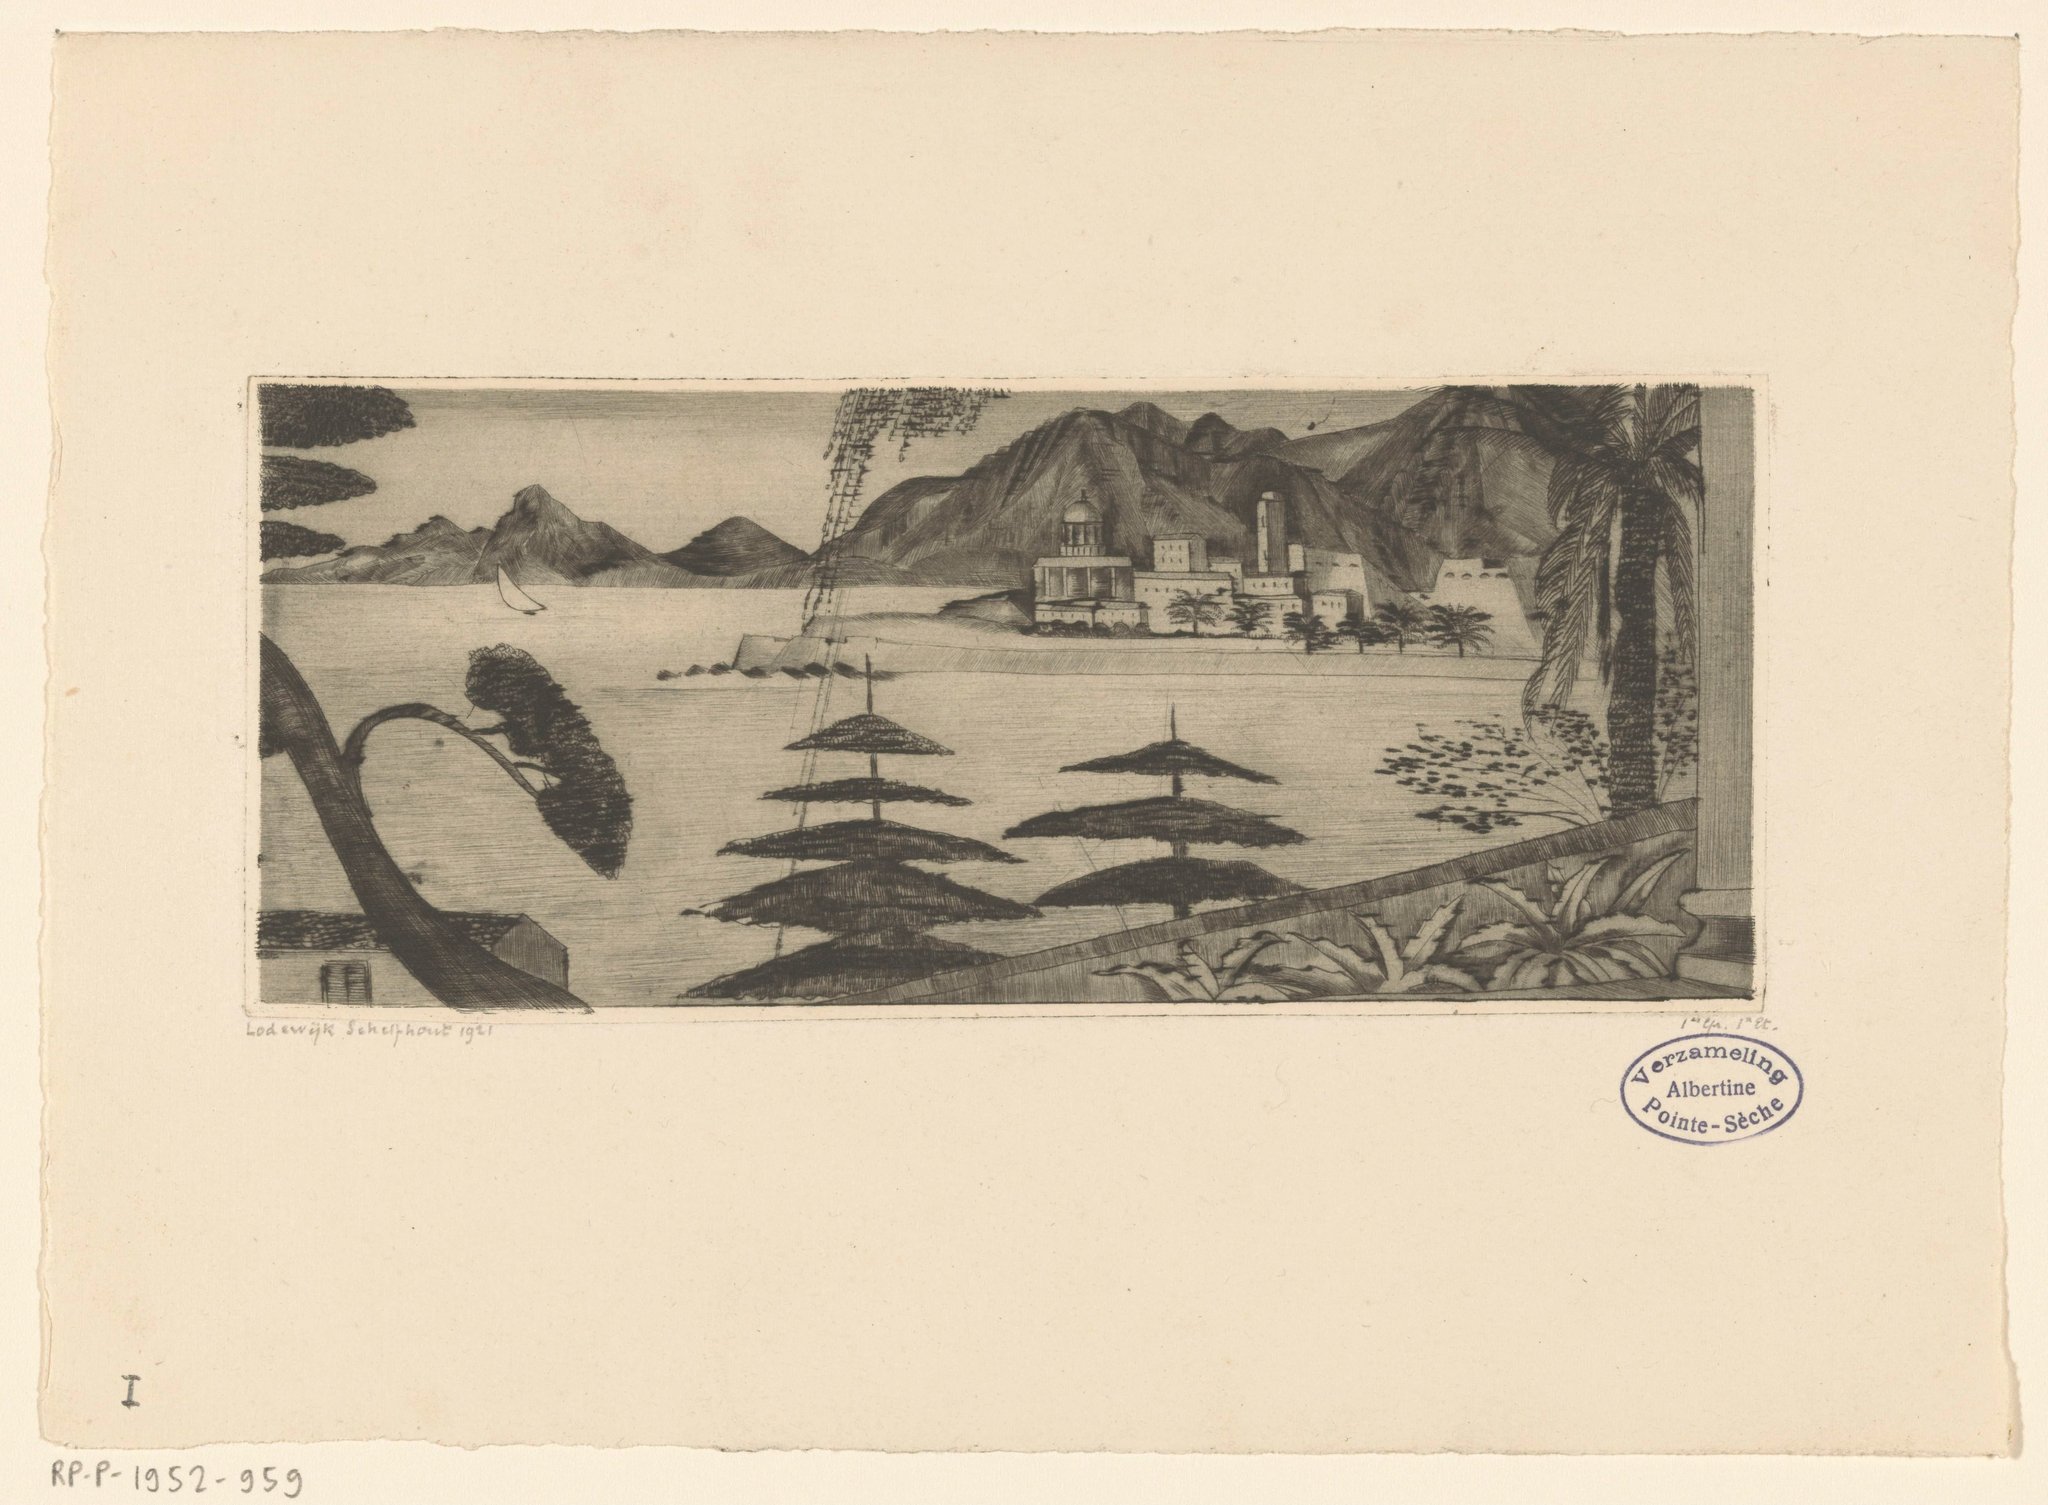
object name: print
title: Ajaccio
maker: lodewijk schelfhout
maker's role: draughtsman, print maker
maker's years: 1881-1943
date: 1921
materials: paper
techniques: drypoint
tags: gulf, bay, city-view, and landscape with man-made constructions, mountains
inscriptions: collector's mark: Lugt 5i, collector's mark: Lugt 2760, collector's mark: Lugt 2228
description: De stad Ajaccio en de omliggende baai op het eiland Corsica. Op de achtergrond bergen.